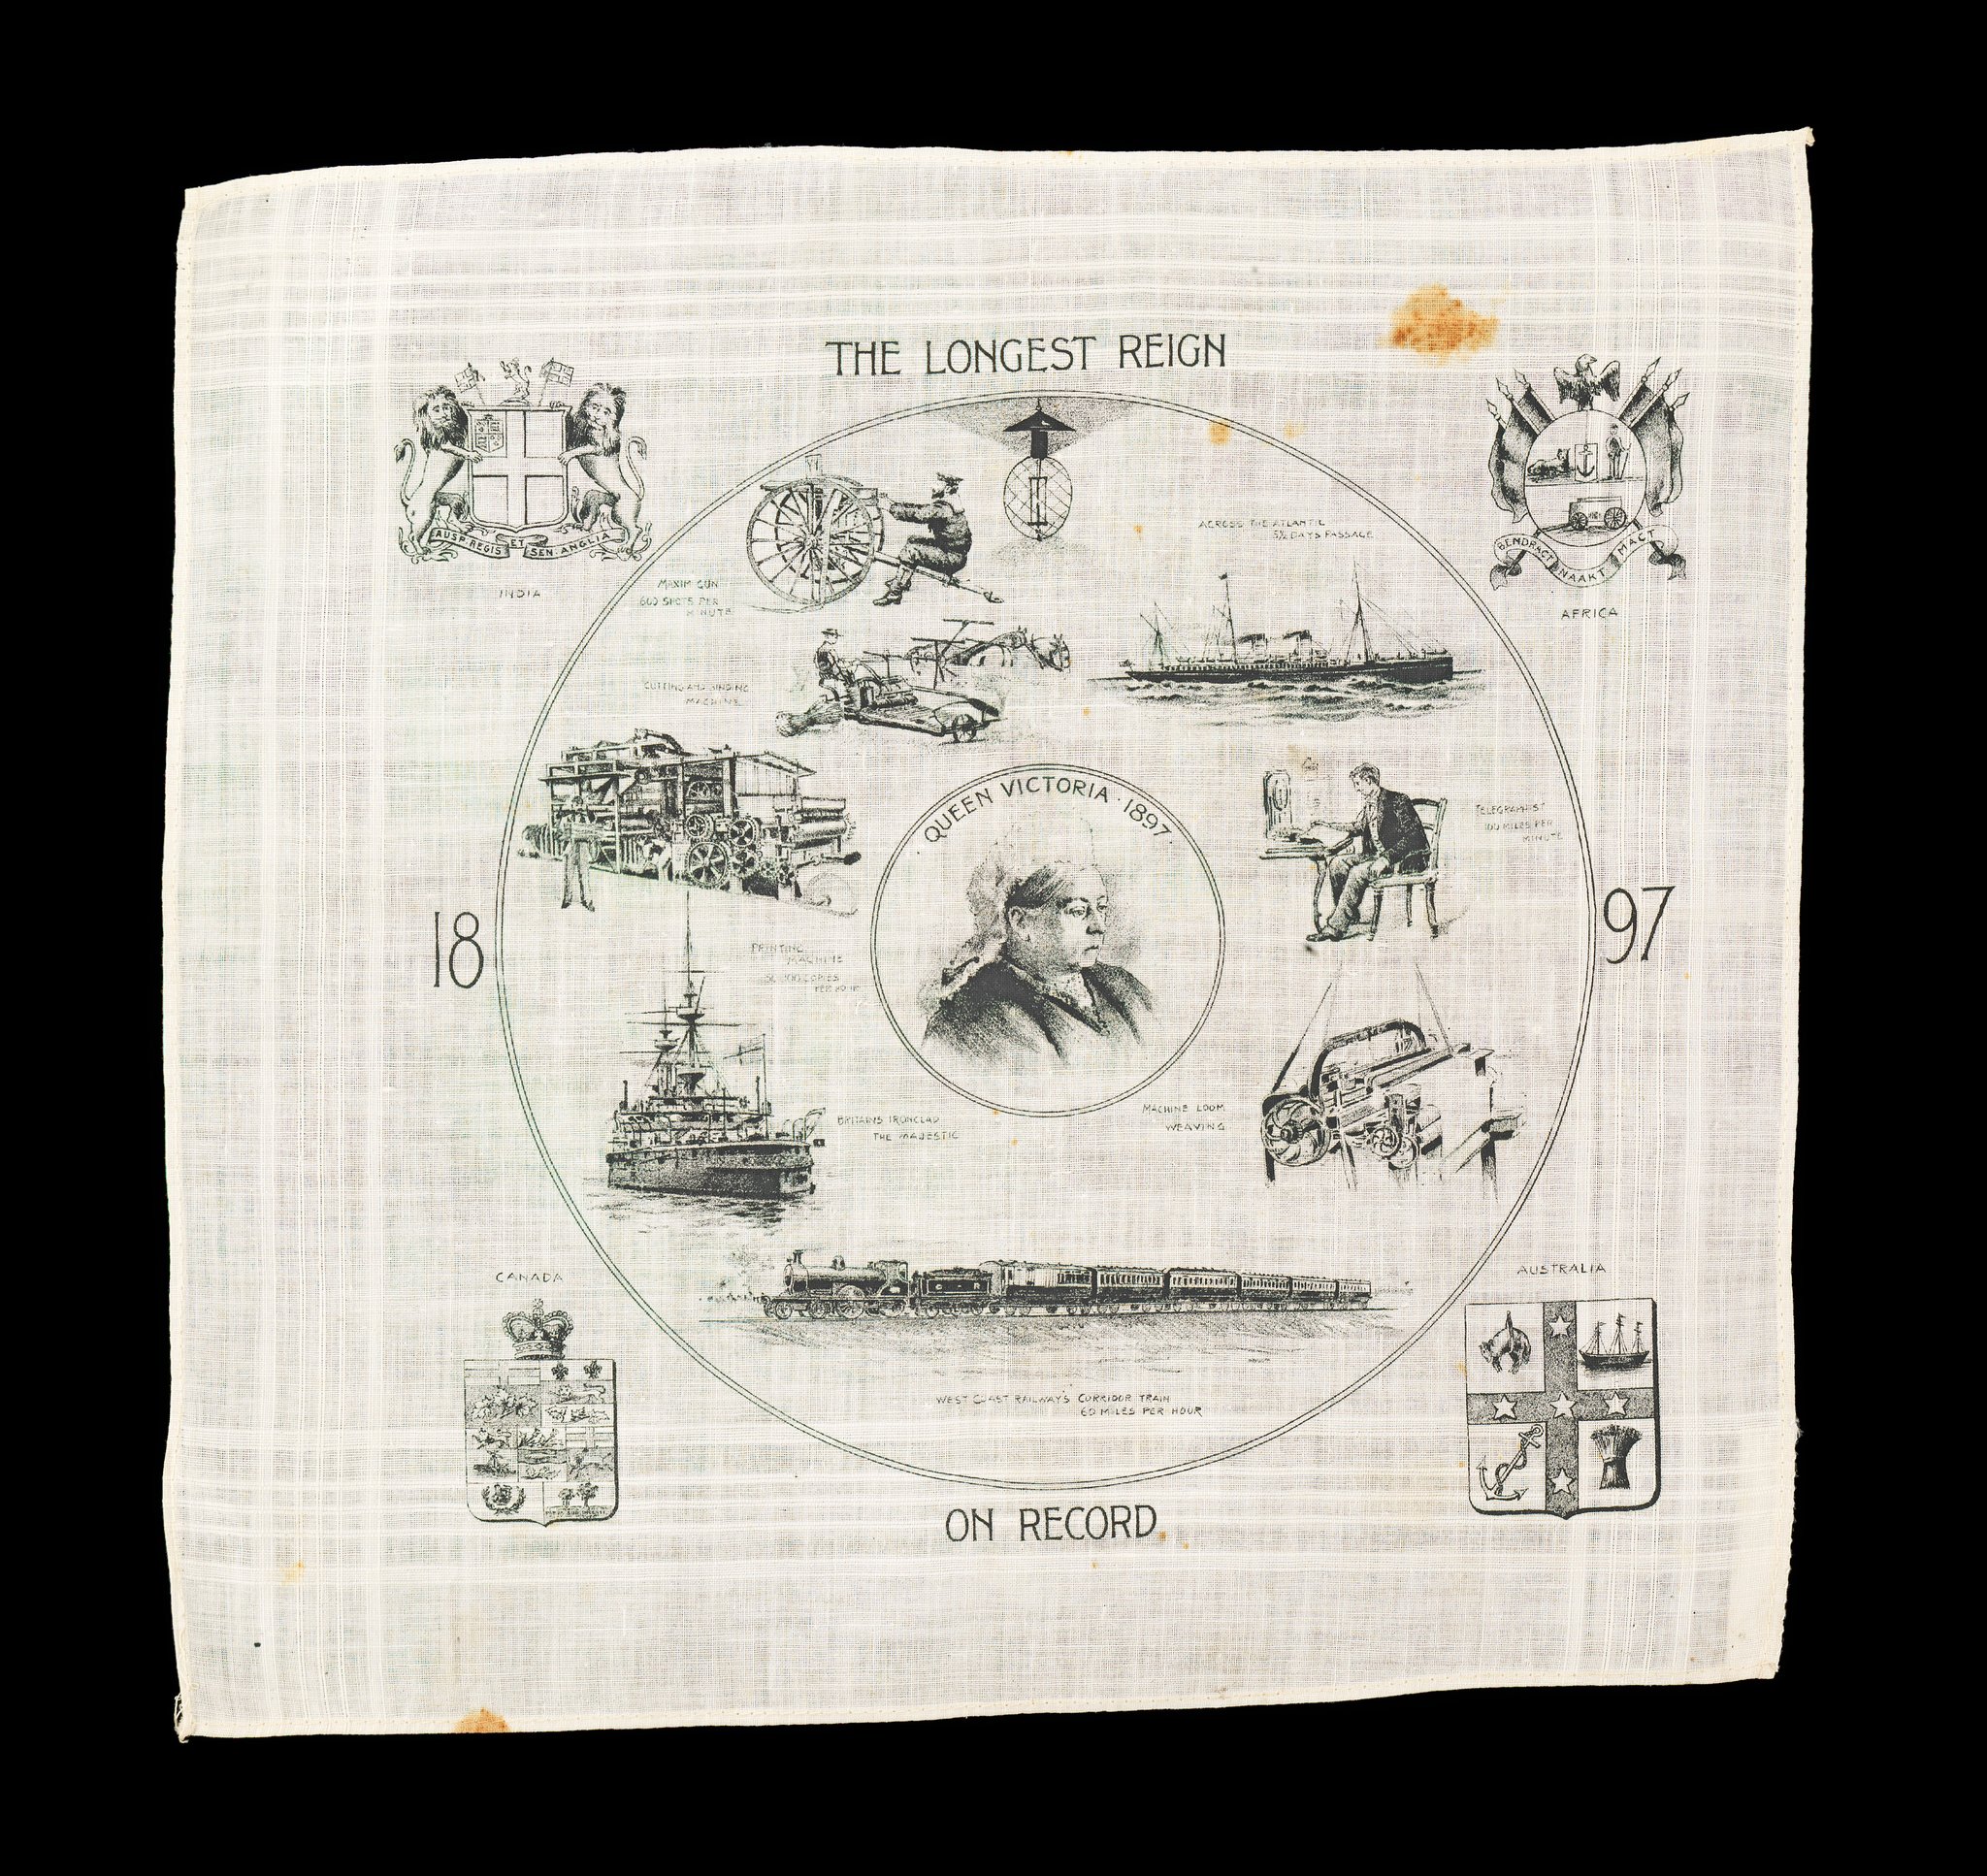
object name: handkerchief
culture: british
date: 1897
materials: linen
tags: industry,ships,trains,queen victoria